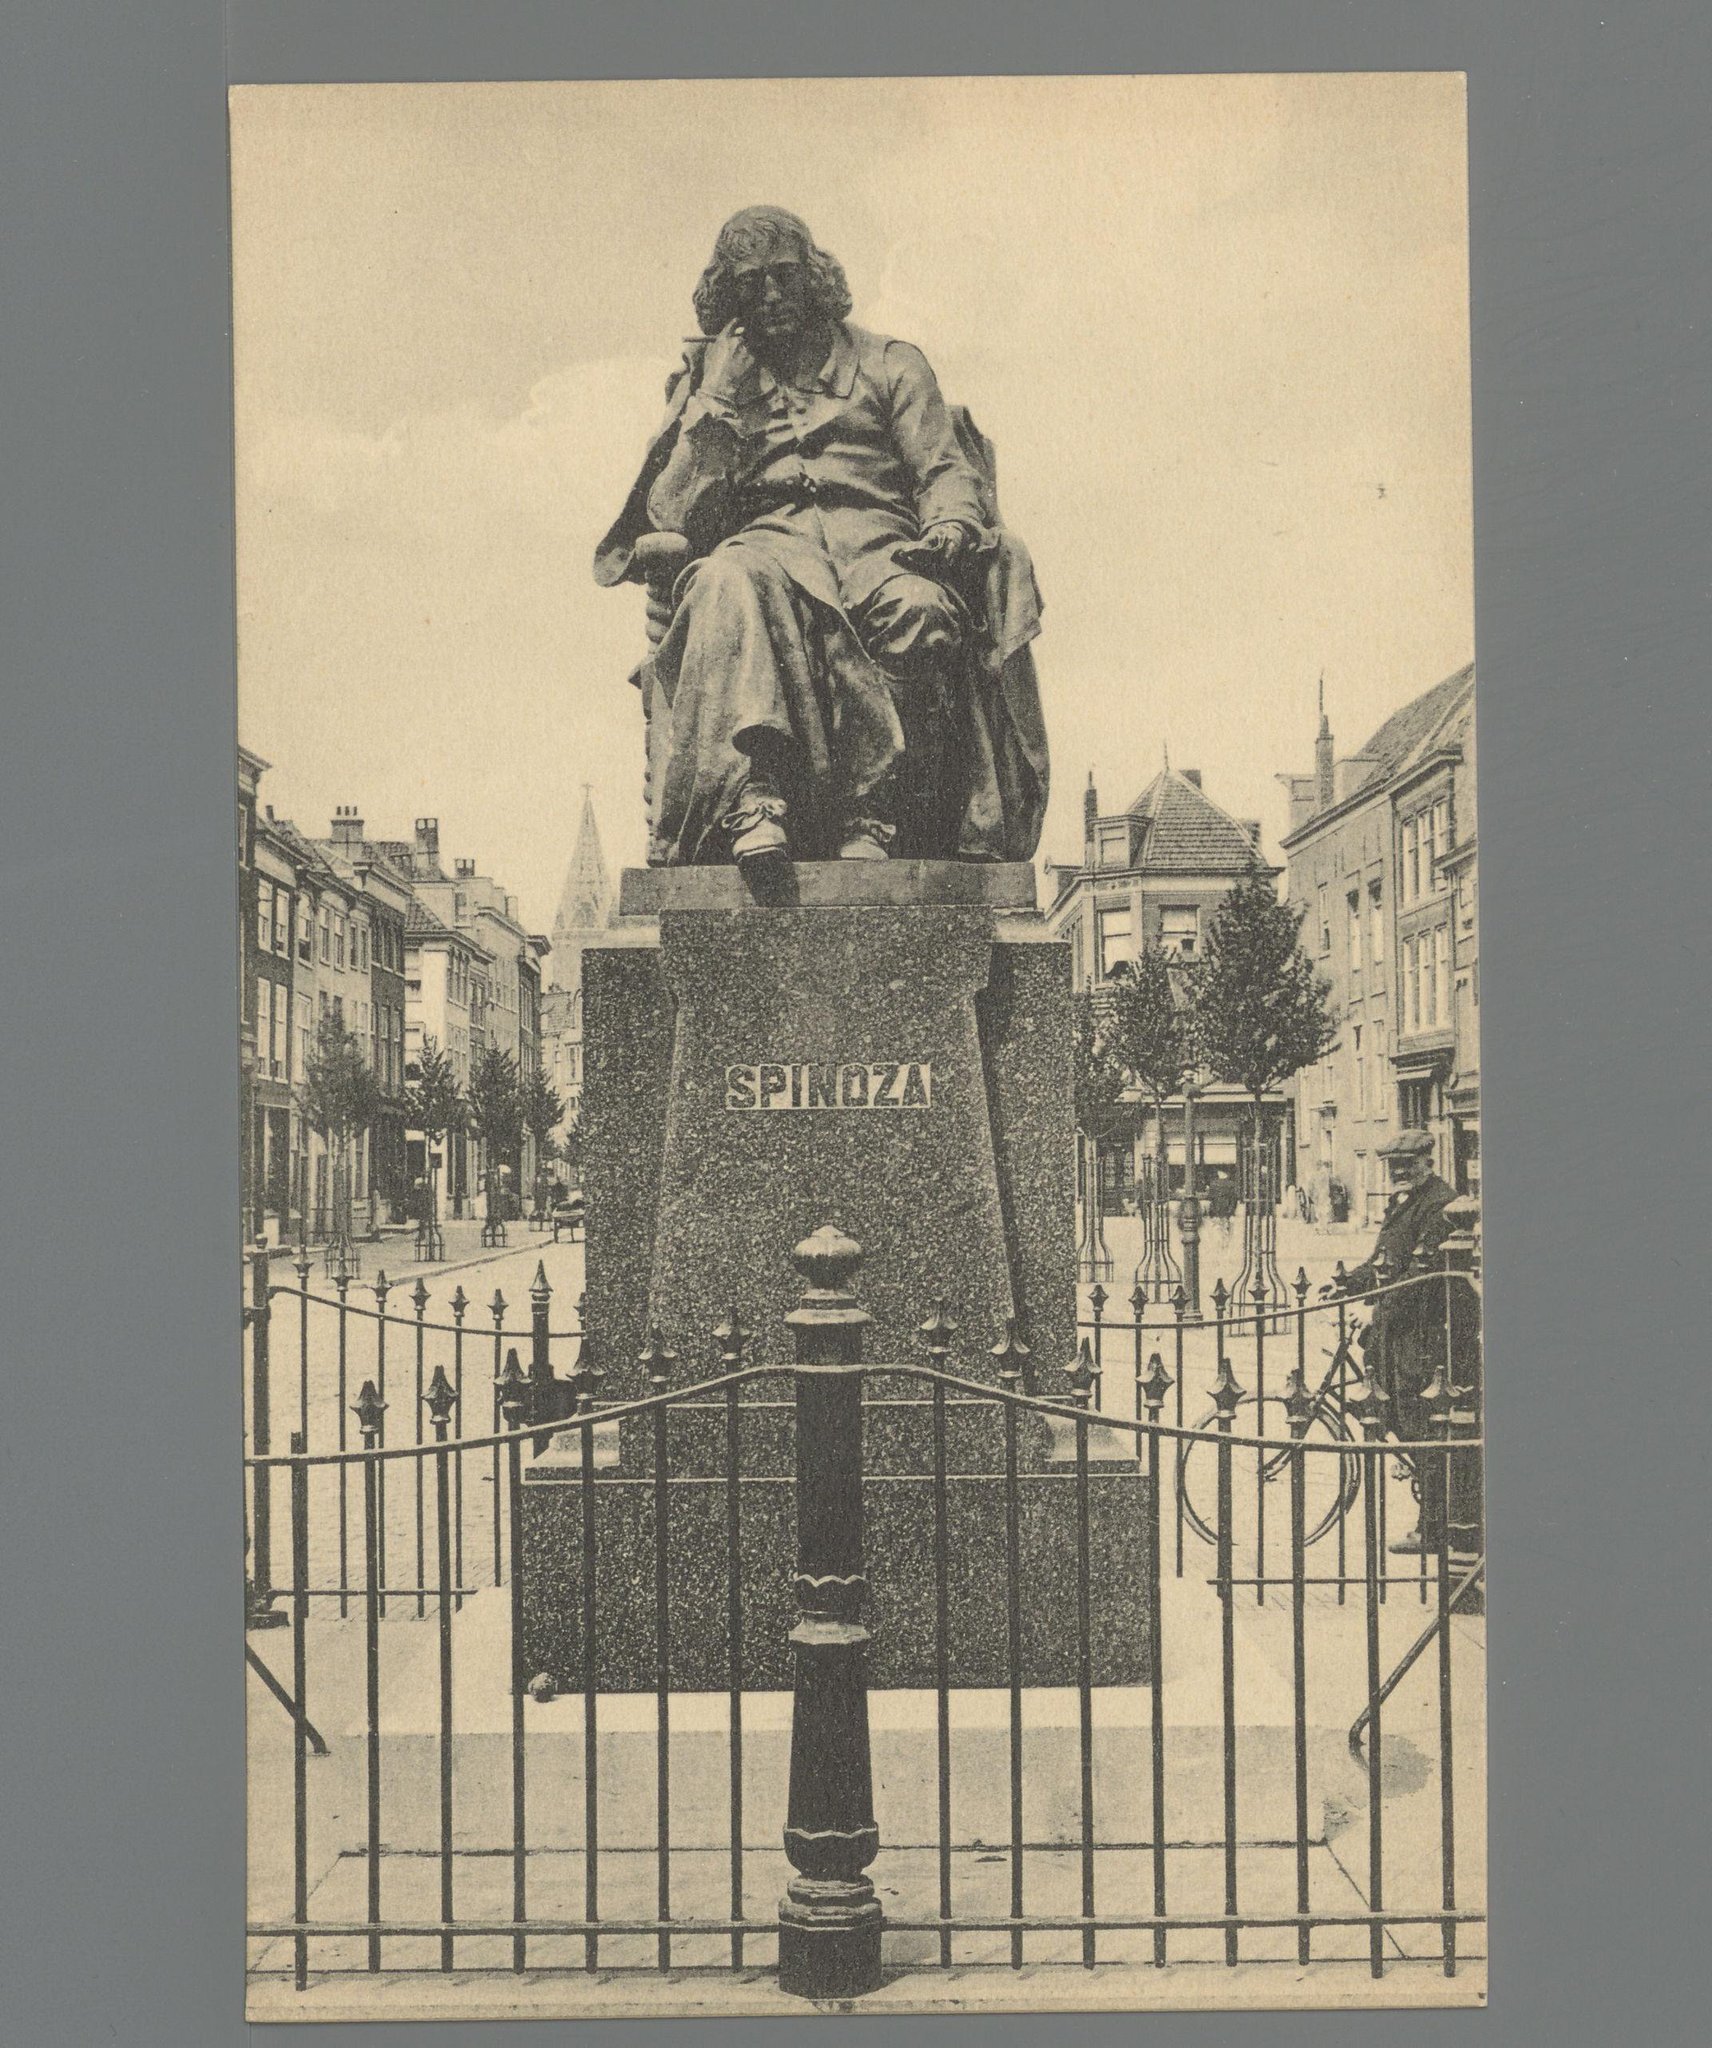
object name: ansichtkaart, prentbriefkaart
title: Spinoza-Monument. den Haag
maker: Anonymous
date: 1911-1919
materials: cardboard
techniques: photograph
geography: the hague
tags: baruch de spinoza, fence, wall, paling, monument, statue, street